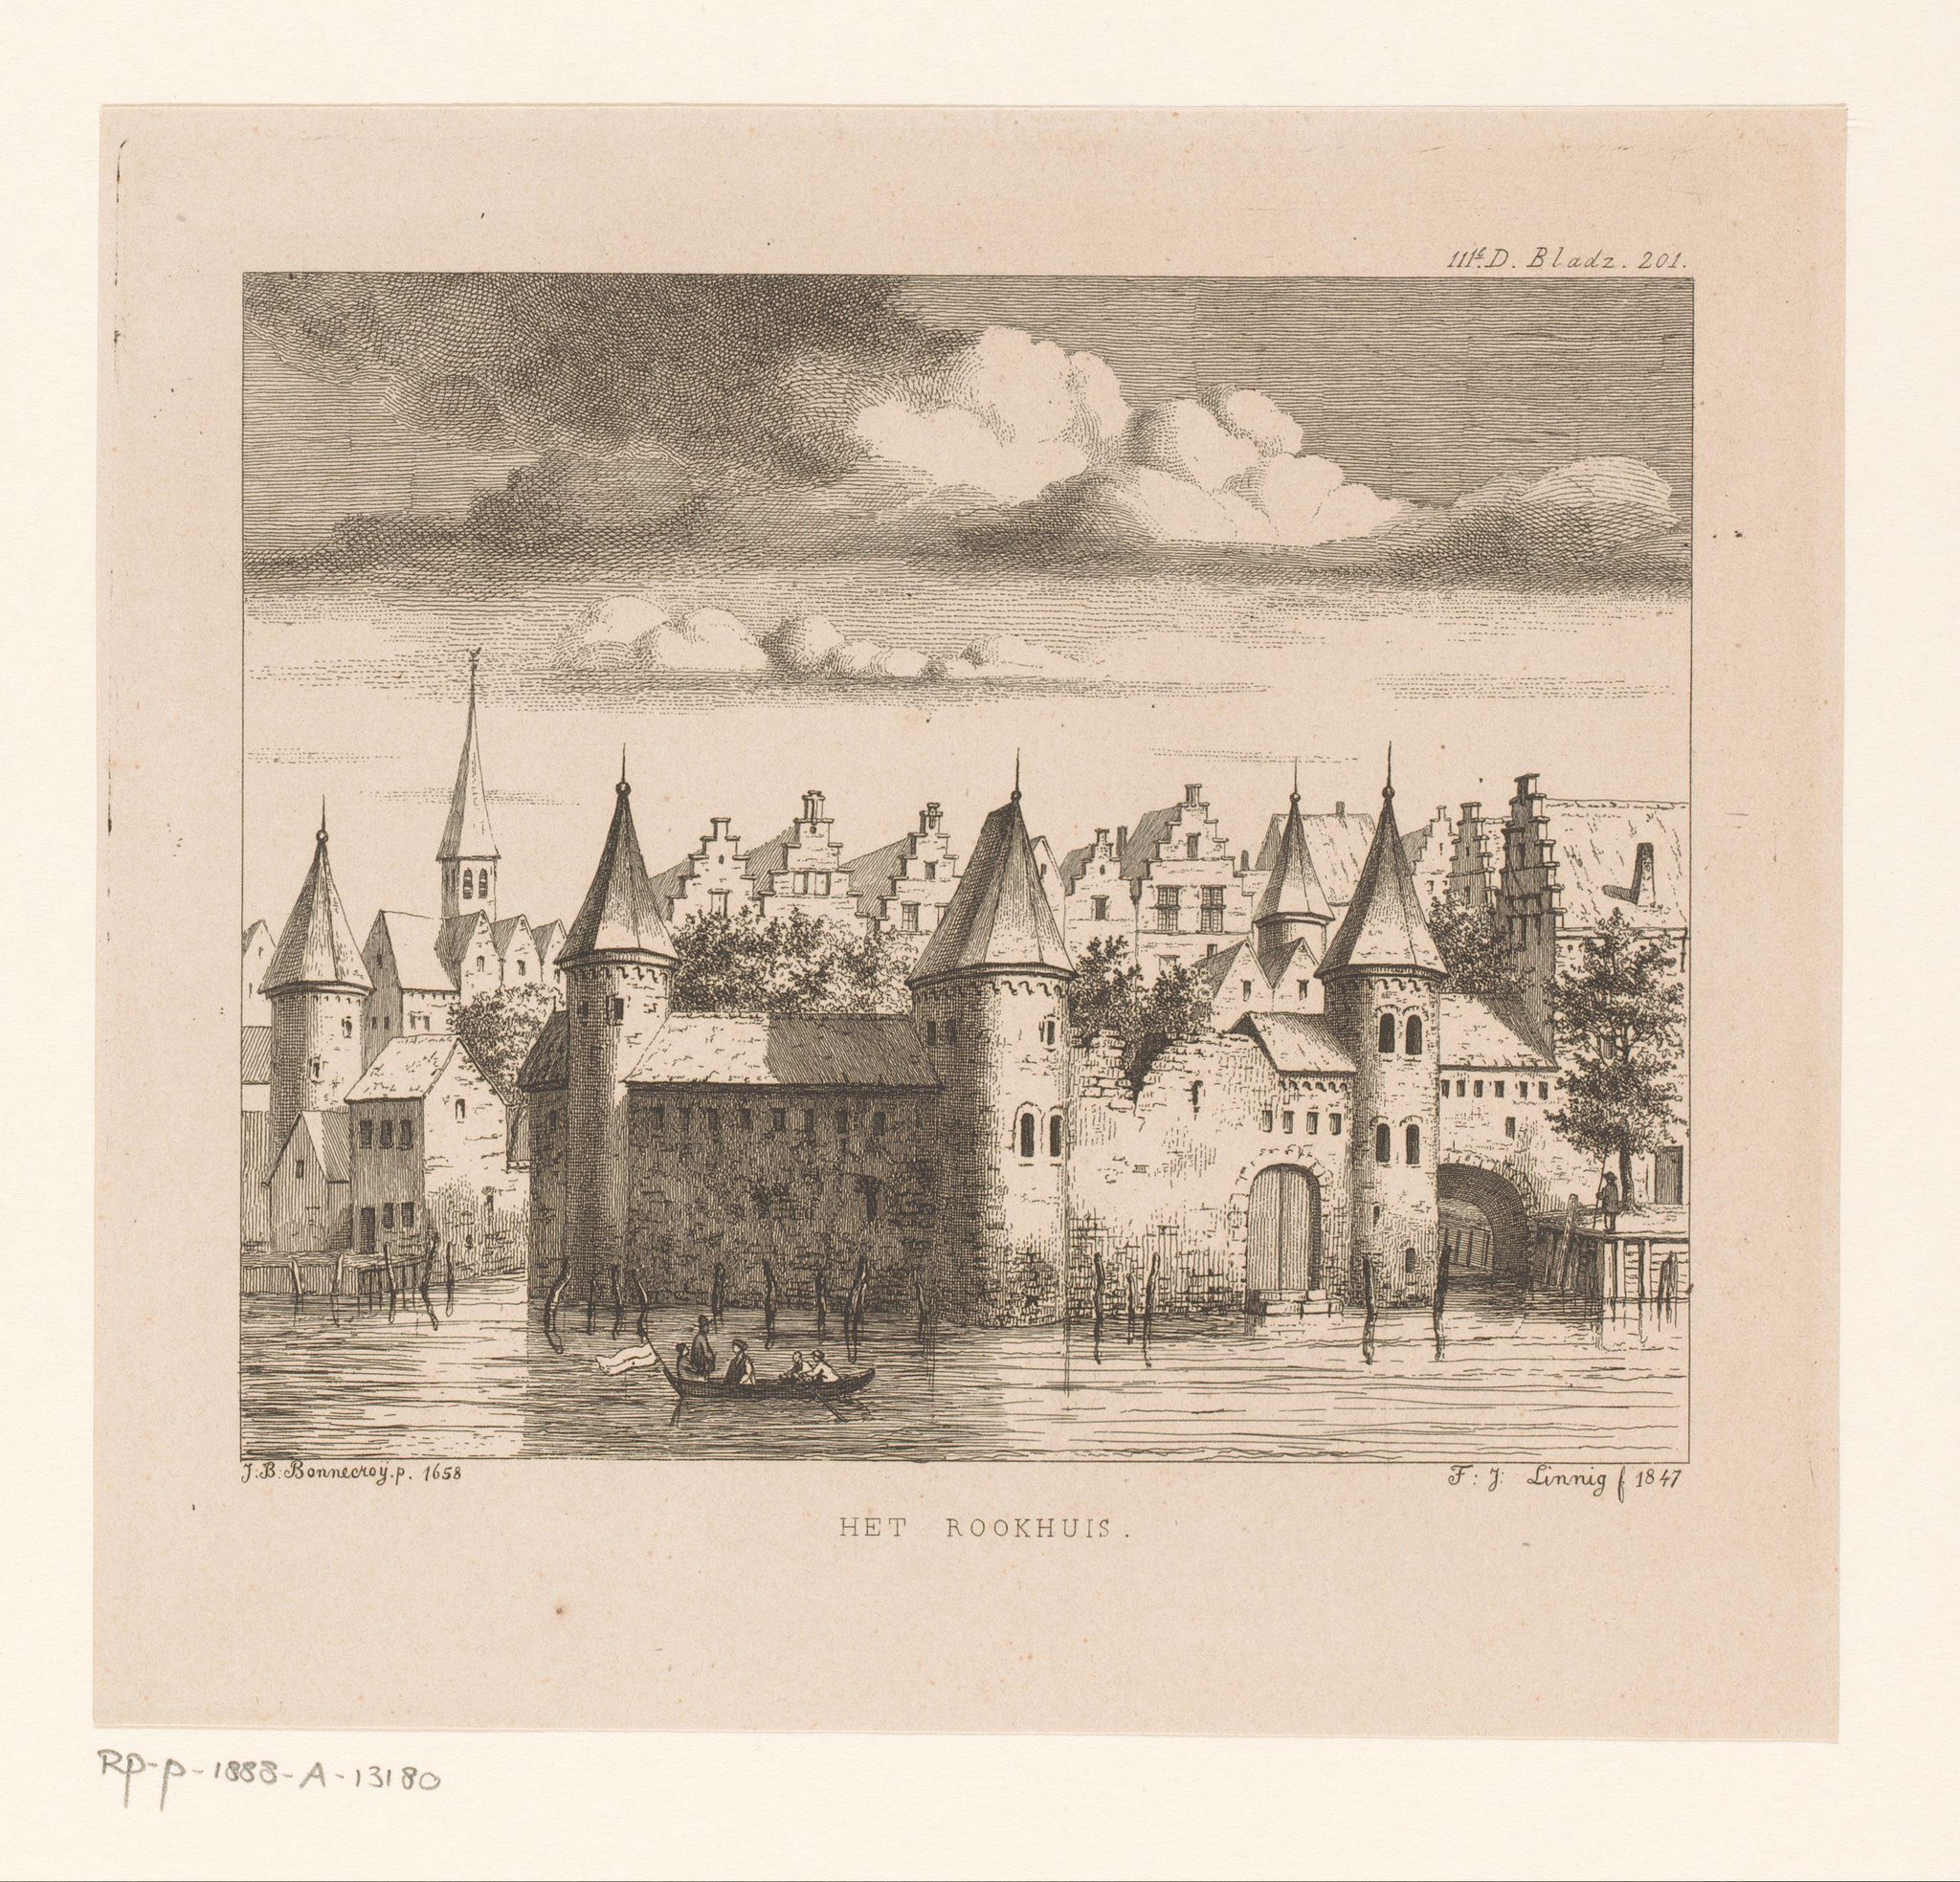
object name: book illustration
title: Gezicht op het Rookhuis in Antwerpen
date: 1847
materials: paper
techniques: etching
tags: city-view in general; 'veduta', antwerp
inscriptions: collector's mark: Lugt 2228